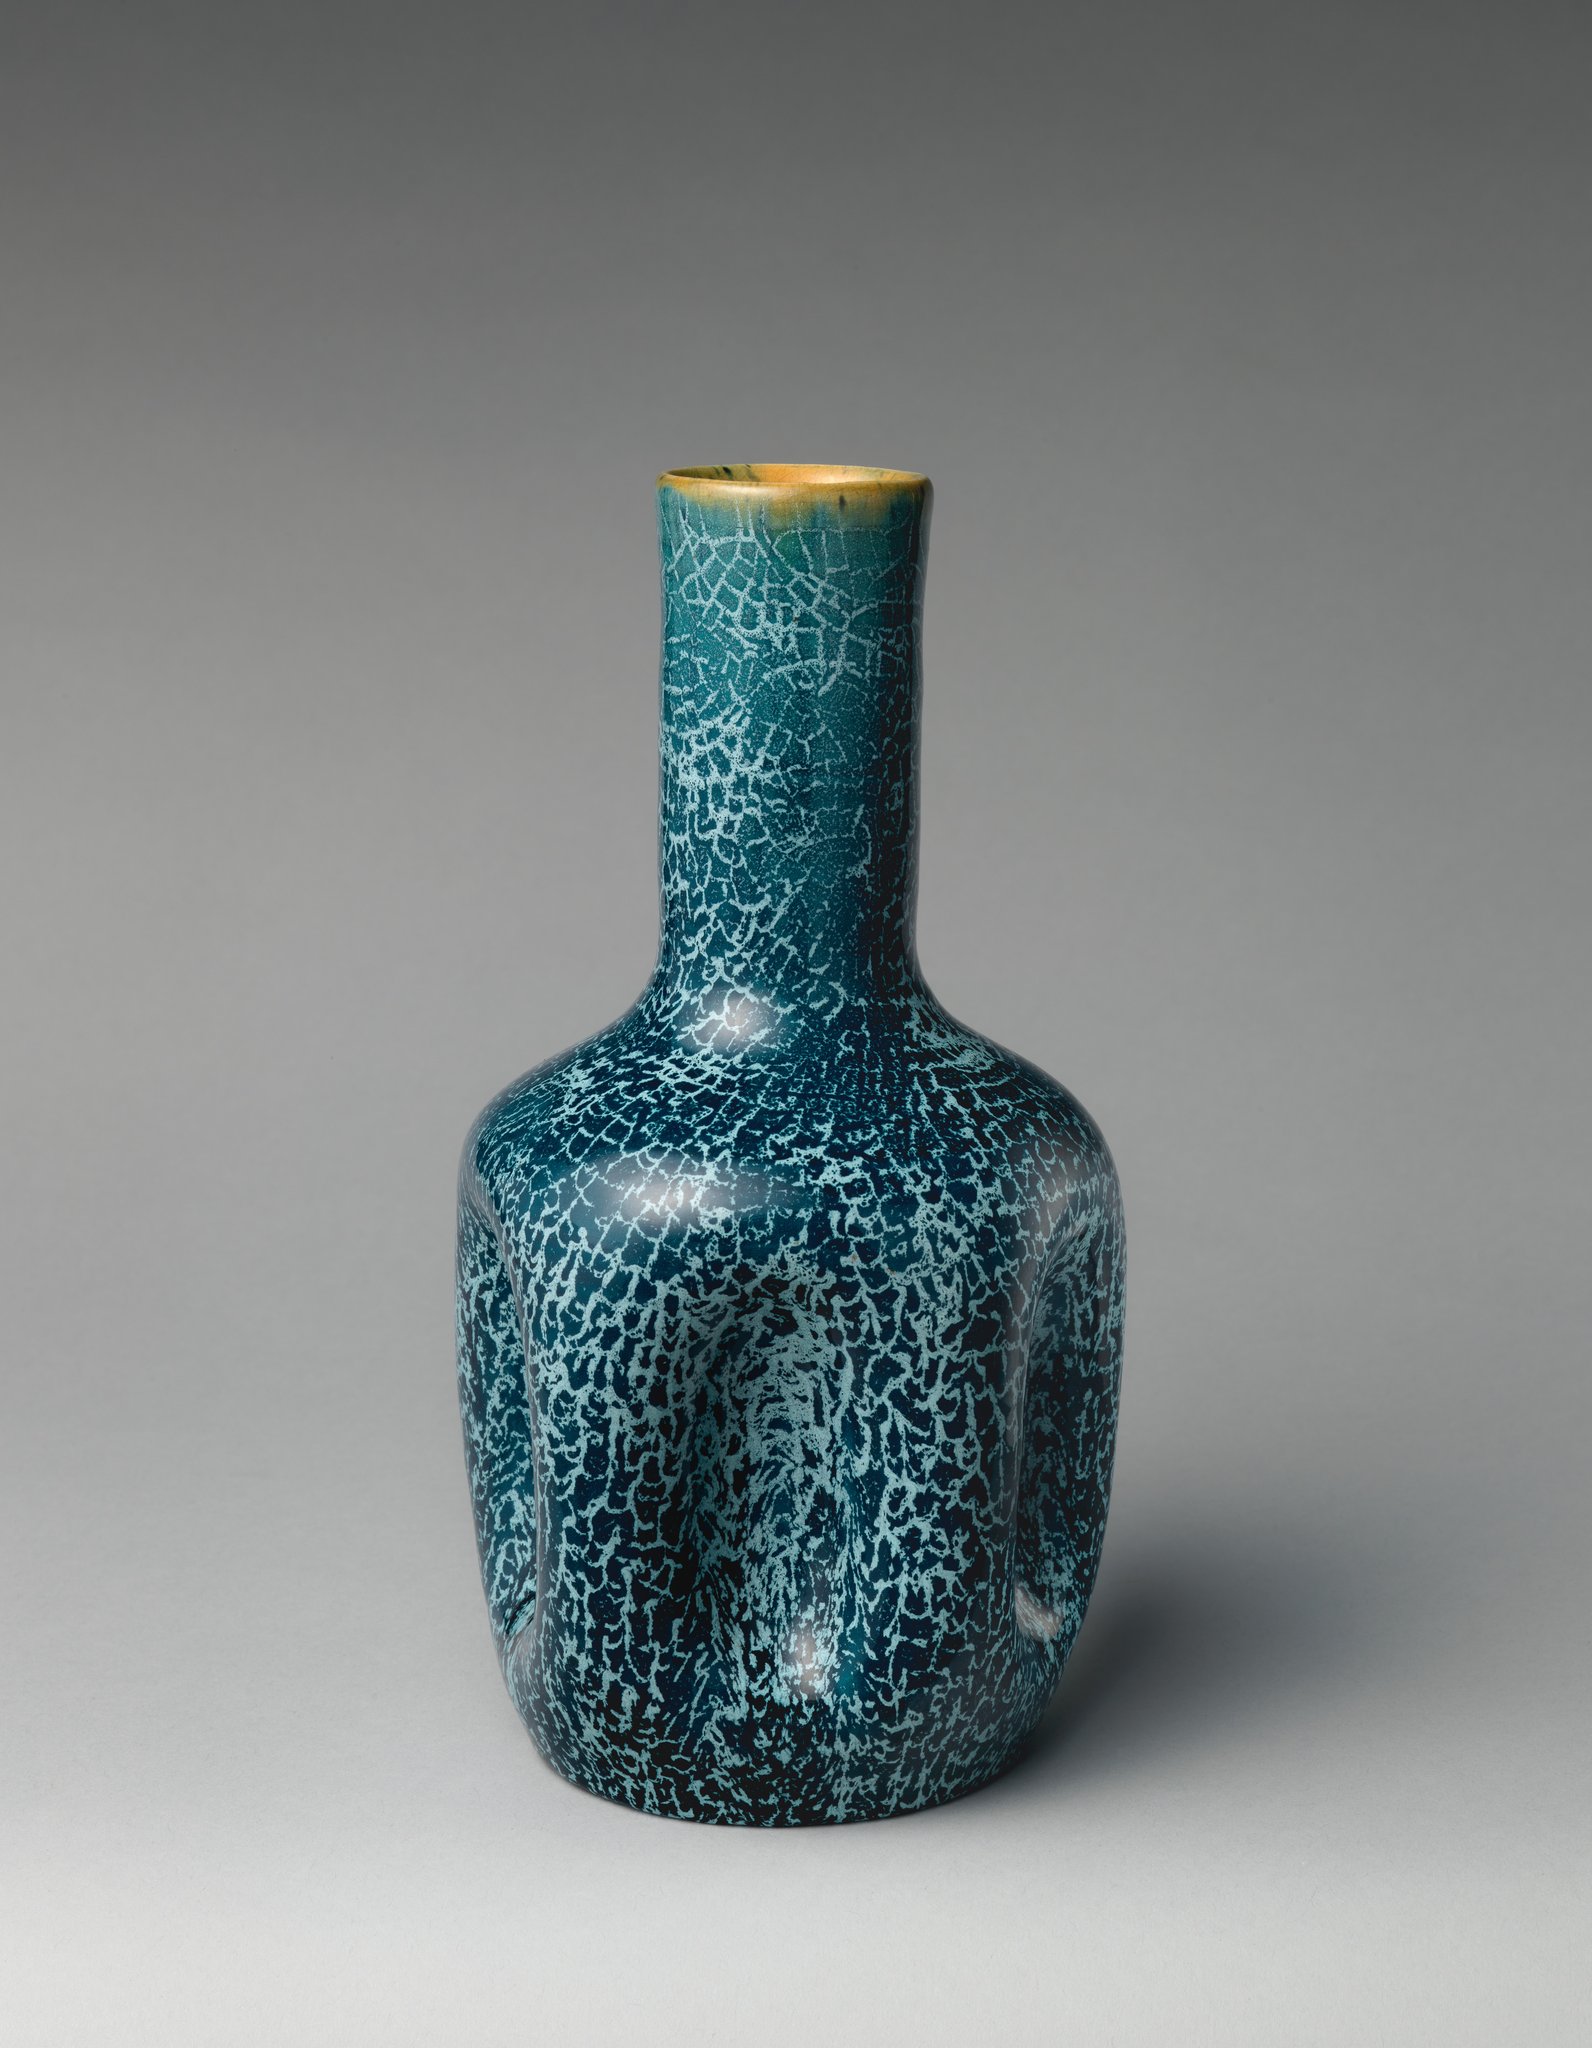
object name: vase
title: Bottle vase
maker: christopher dresser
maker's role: designer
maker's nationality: british, scottish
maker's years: 1834-1904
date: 1882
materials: earthenware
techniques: glazing